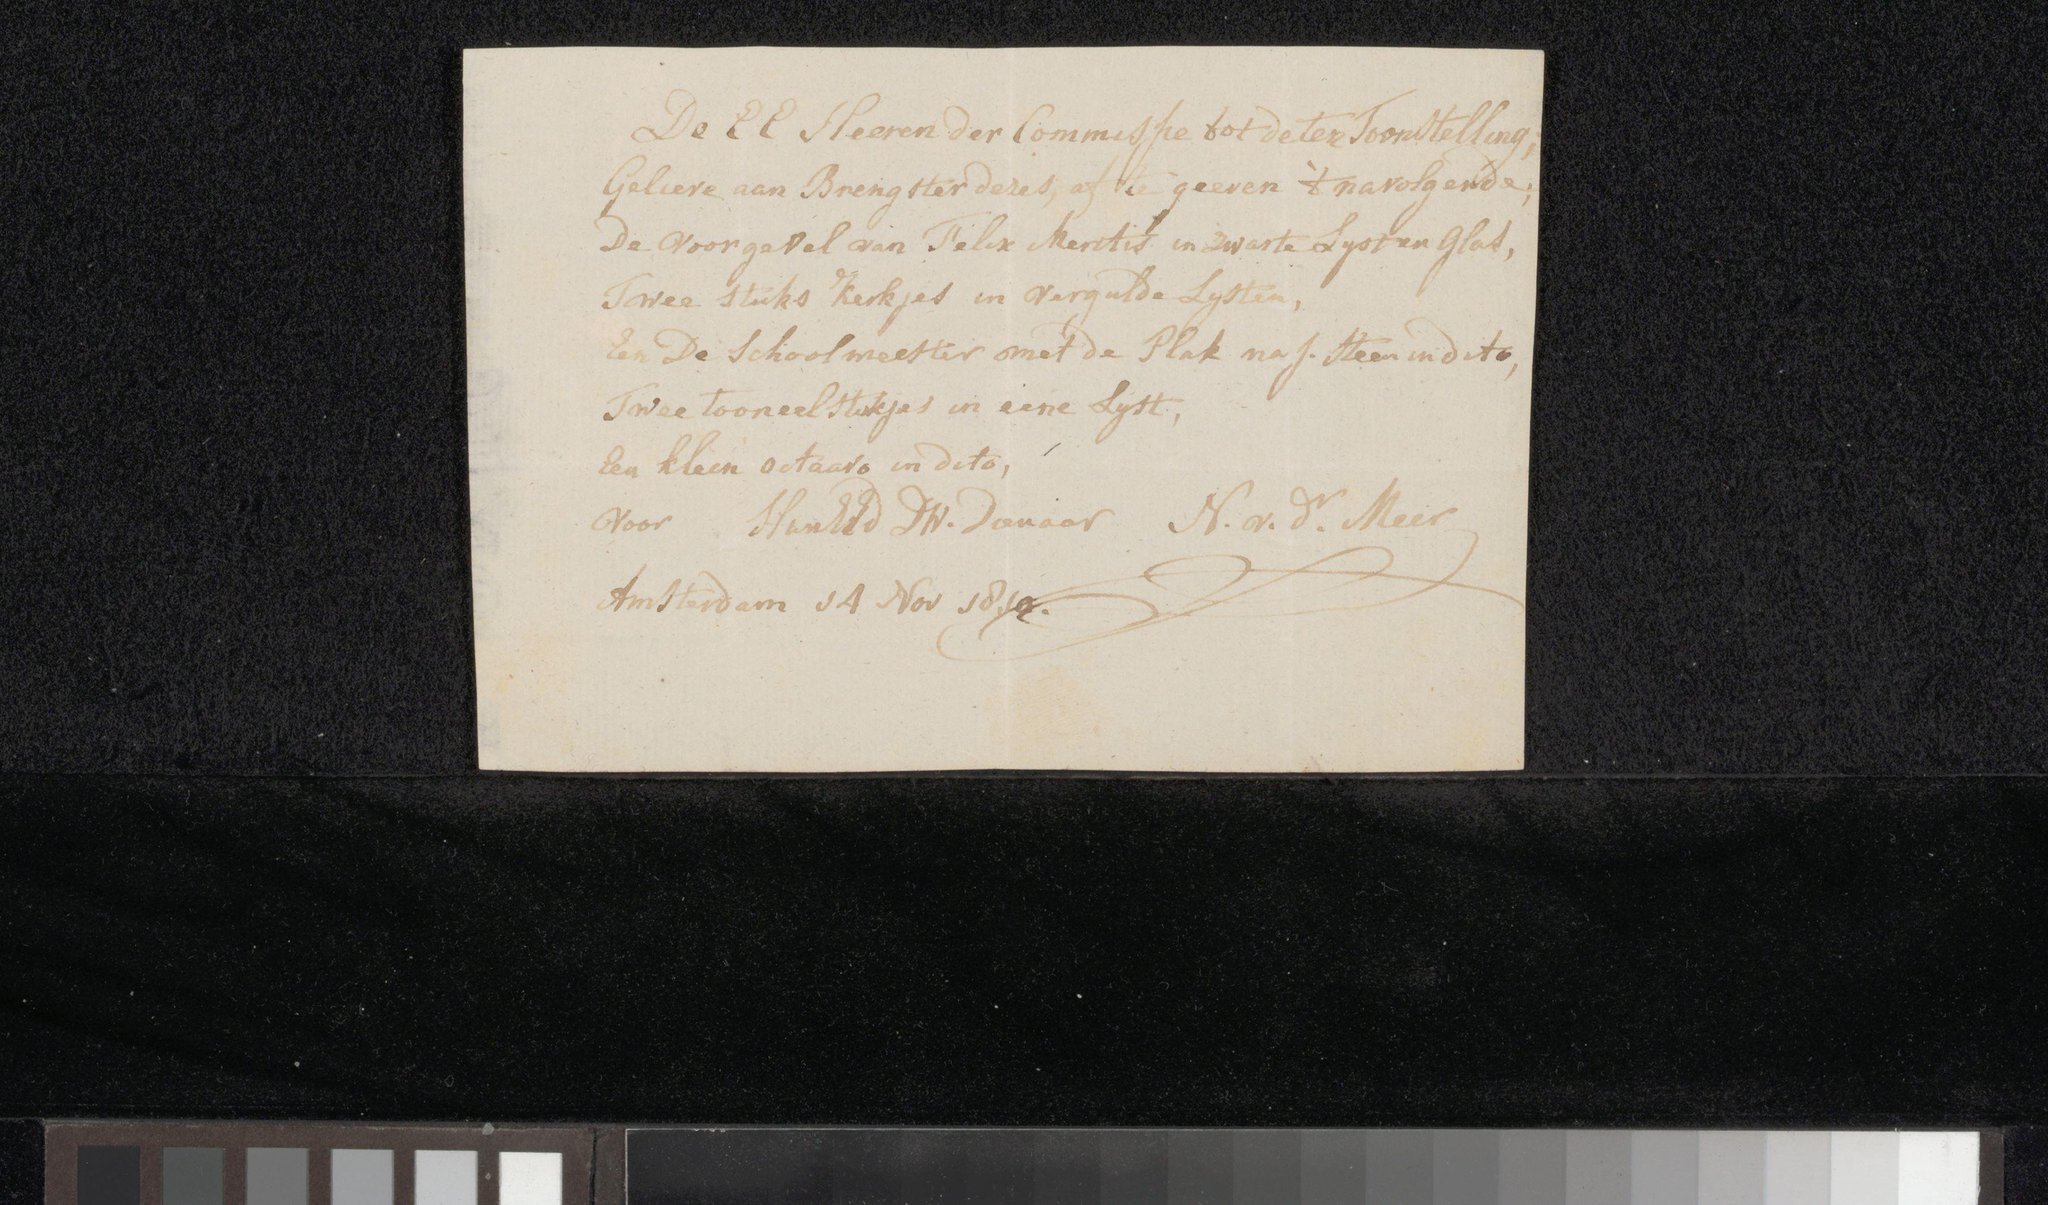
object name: letter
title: Brief aan anoniem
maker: noach van der meer (ii)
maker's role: draughtsman, print maker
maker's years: 1741-1822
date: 1810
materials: ink, paper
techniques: pen, writing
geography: amsterdam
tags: exhibition ~ art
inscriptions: collector's mark: ‘RPK’